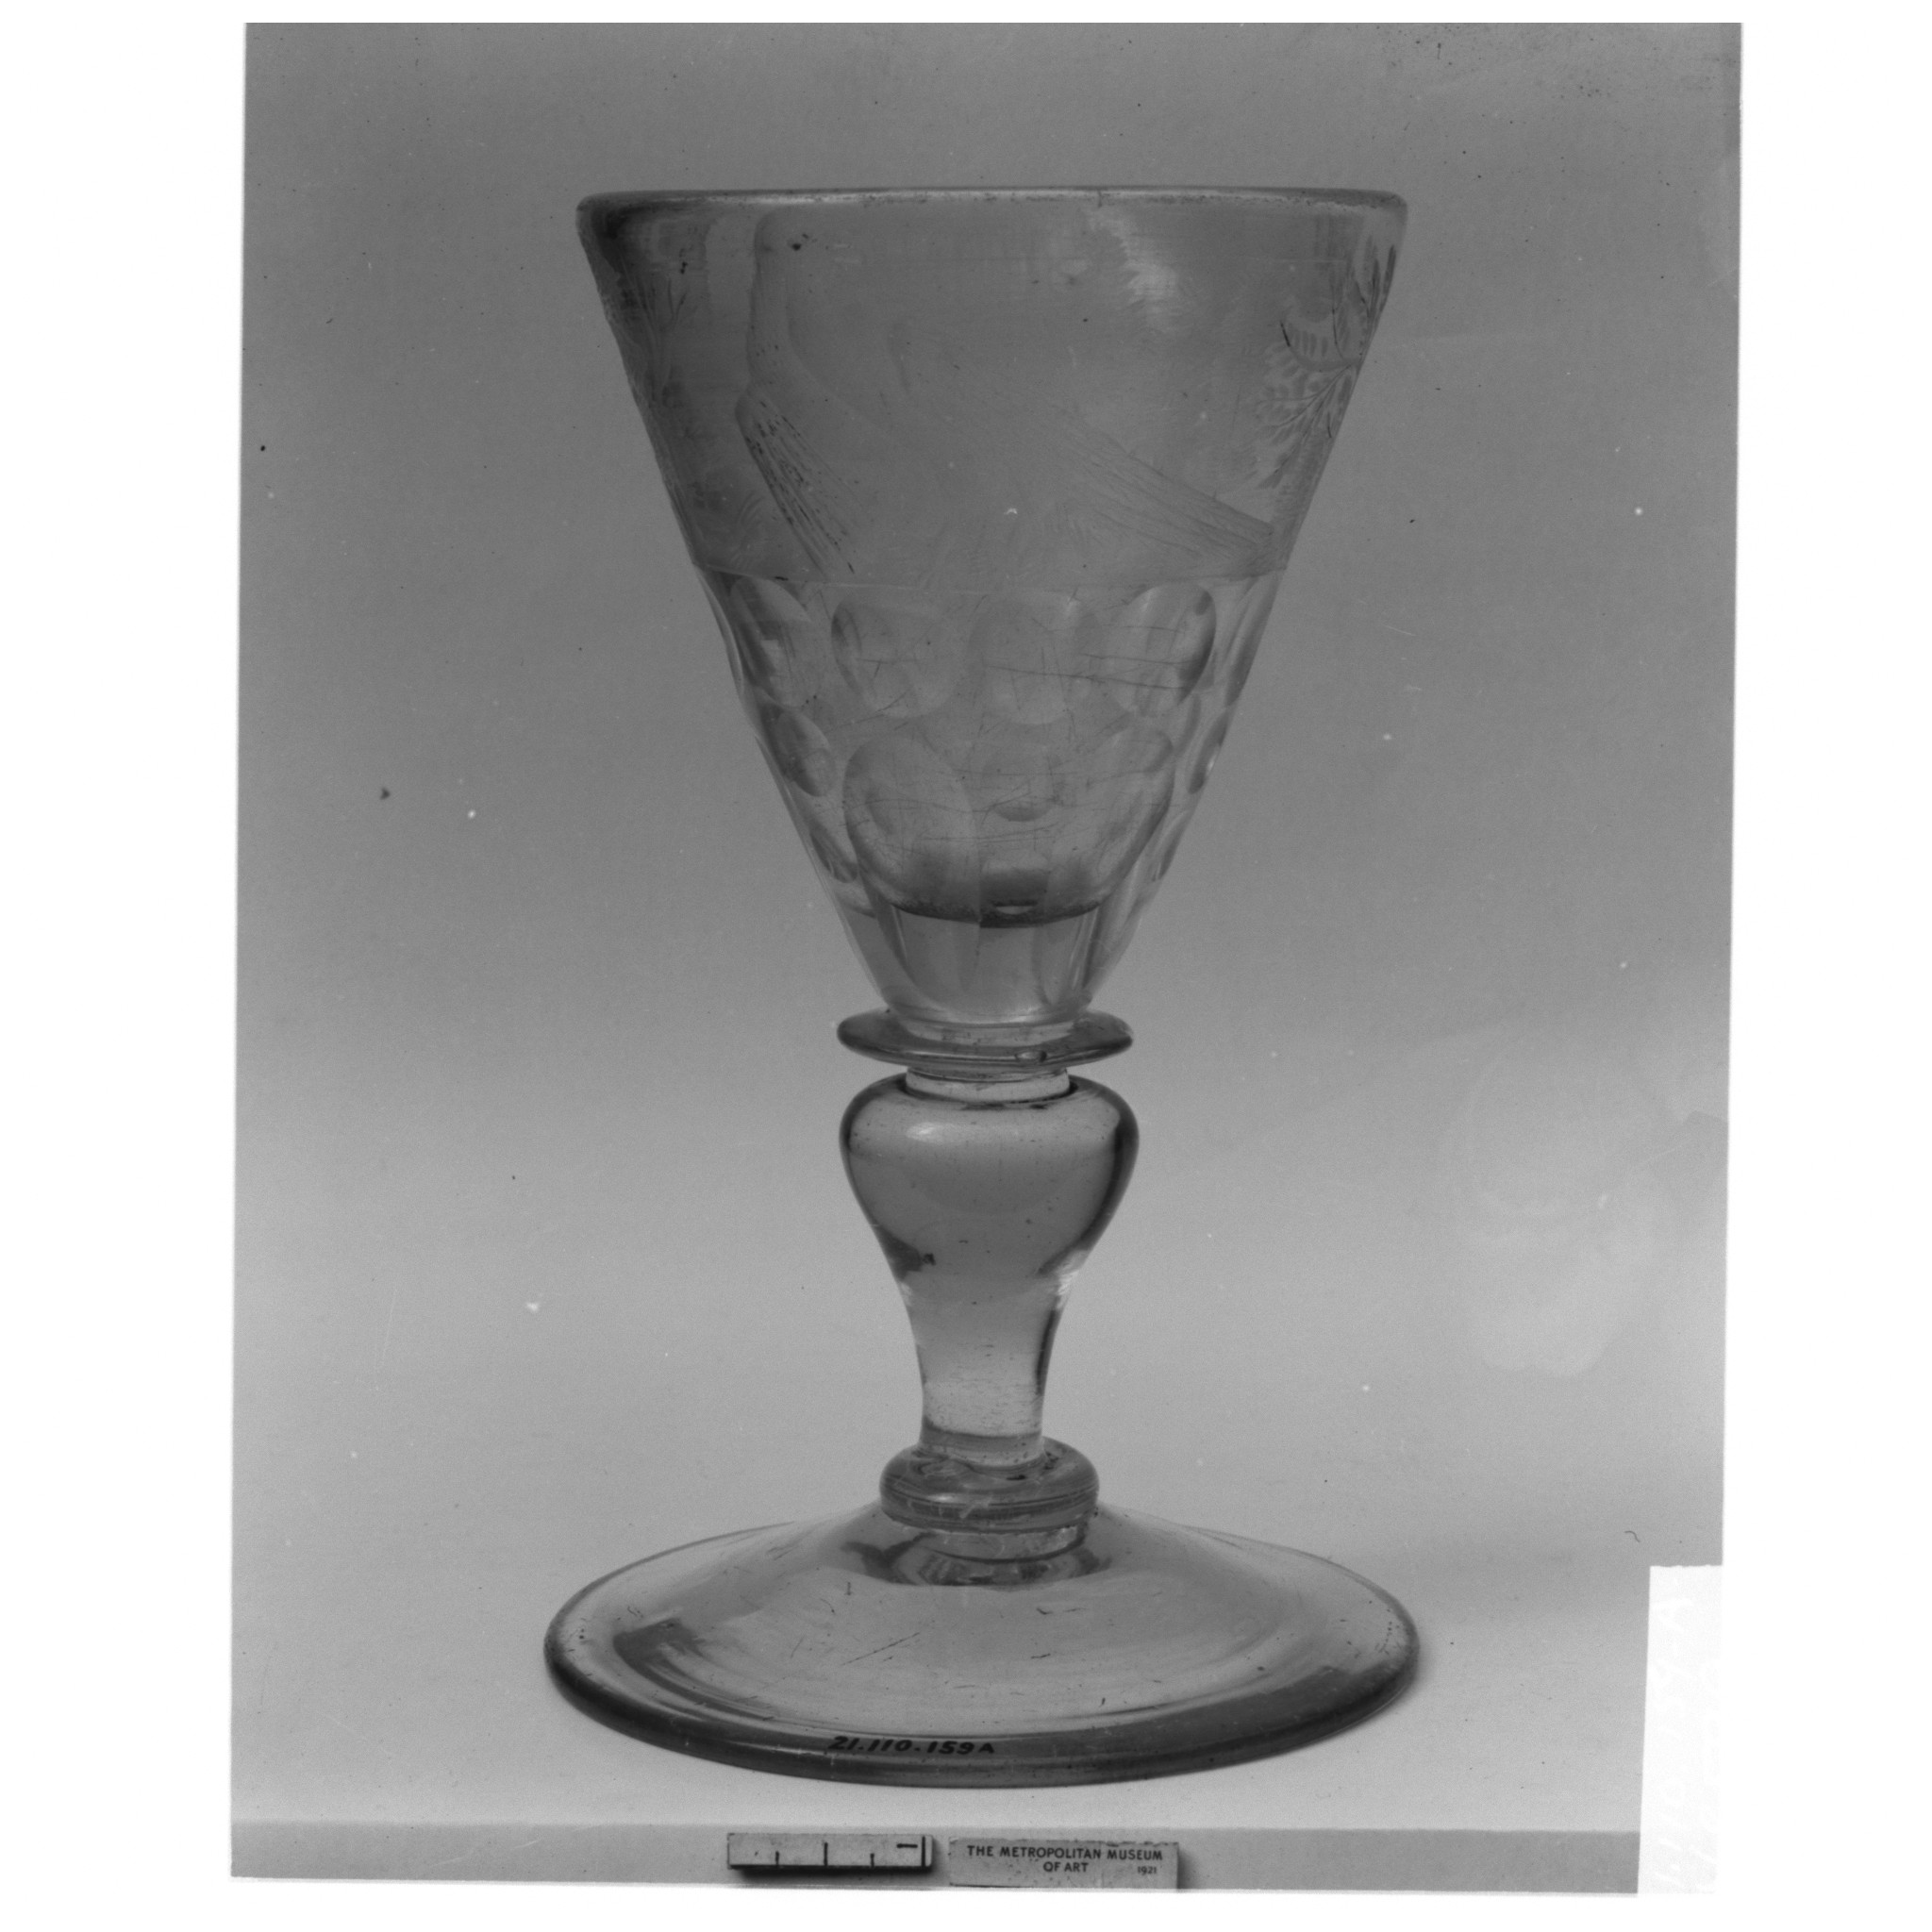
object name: wineglass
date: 1667-1700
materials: glass